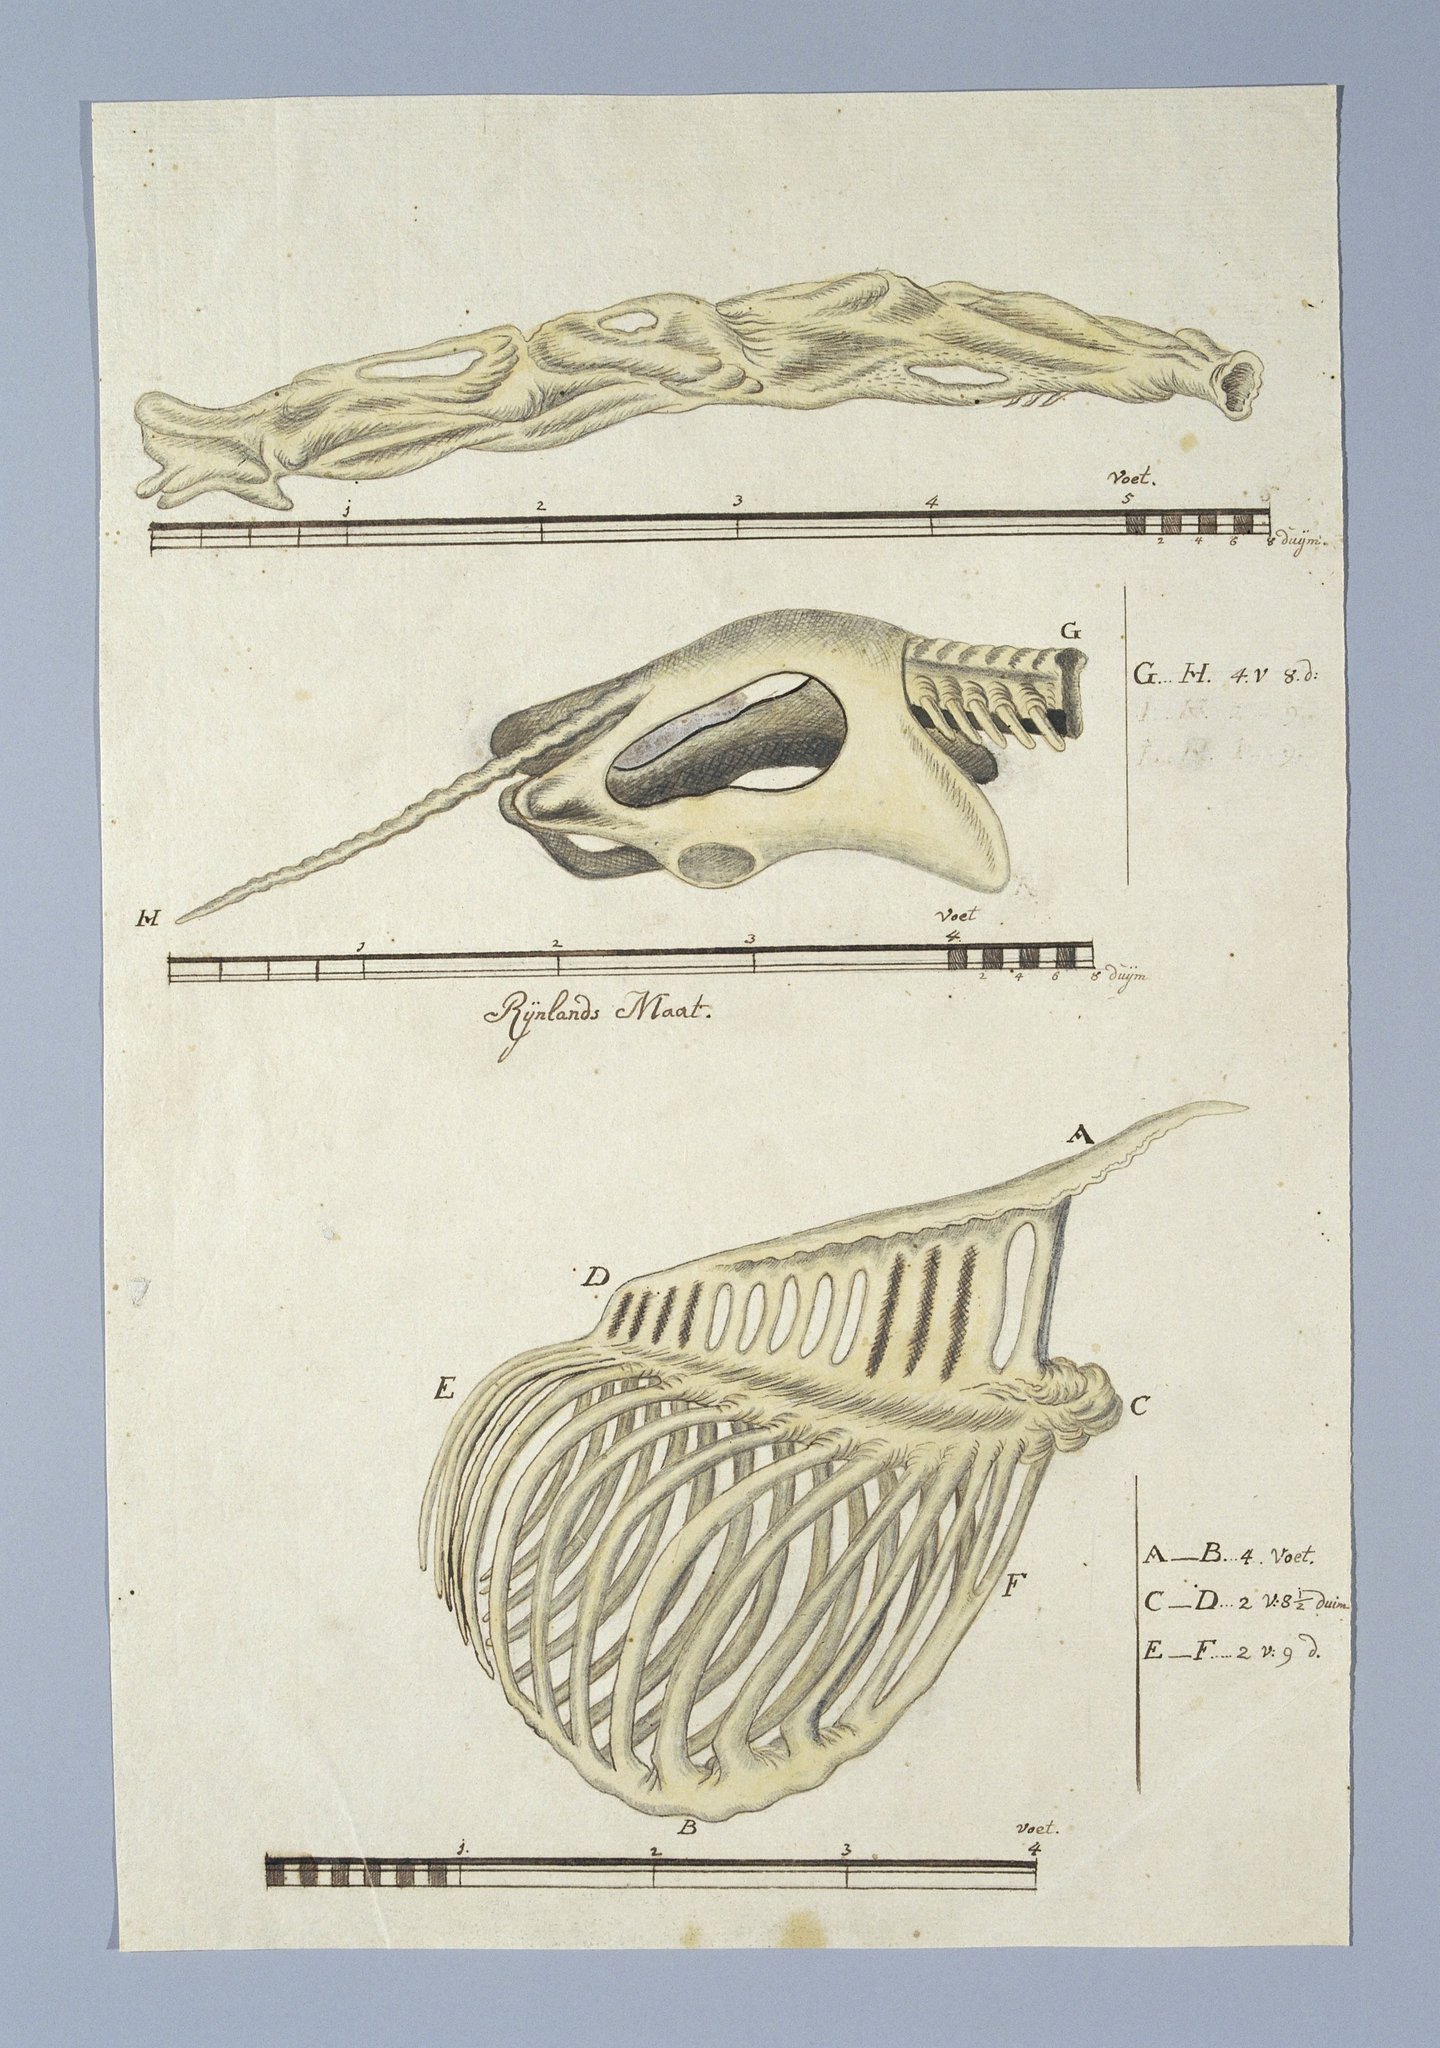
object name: album leaf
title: Giraffa camelopardalis (Giraffe)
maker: robert jacob gordon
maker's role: draughtsman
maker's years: 1743-1795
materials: chalk, ink, paper, pencil, watercolor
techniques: brush, pen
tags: hoofed animals: giraffe (+ skeleton of an animal)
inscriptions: annotation: ‘schaalverdelingen in Rijnlandse voet en duijm; letters A t/m G en aantal voet en duijm per onderdeel’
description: Skeletdelen van een giraf: de nek, het bekken met de staart en de ribbenkast; met schaalverdeling in Rijnlandse maat.